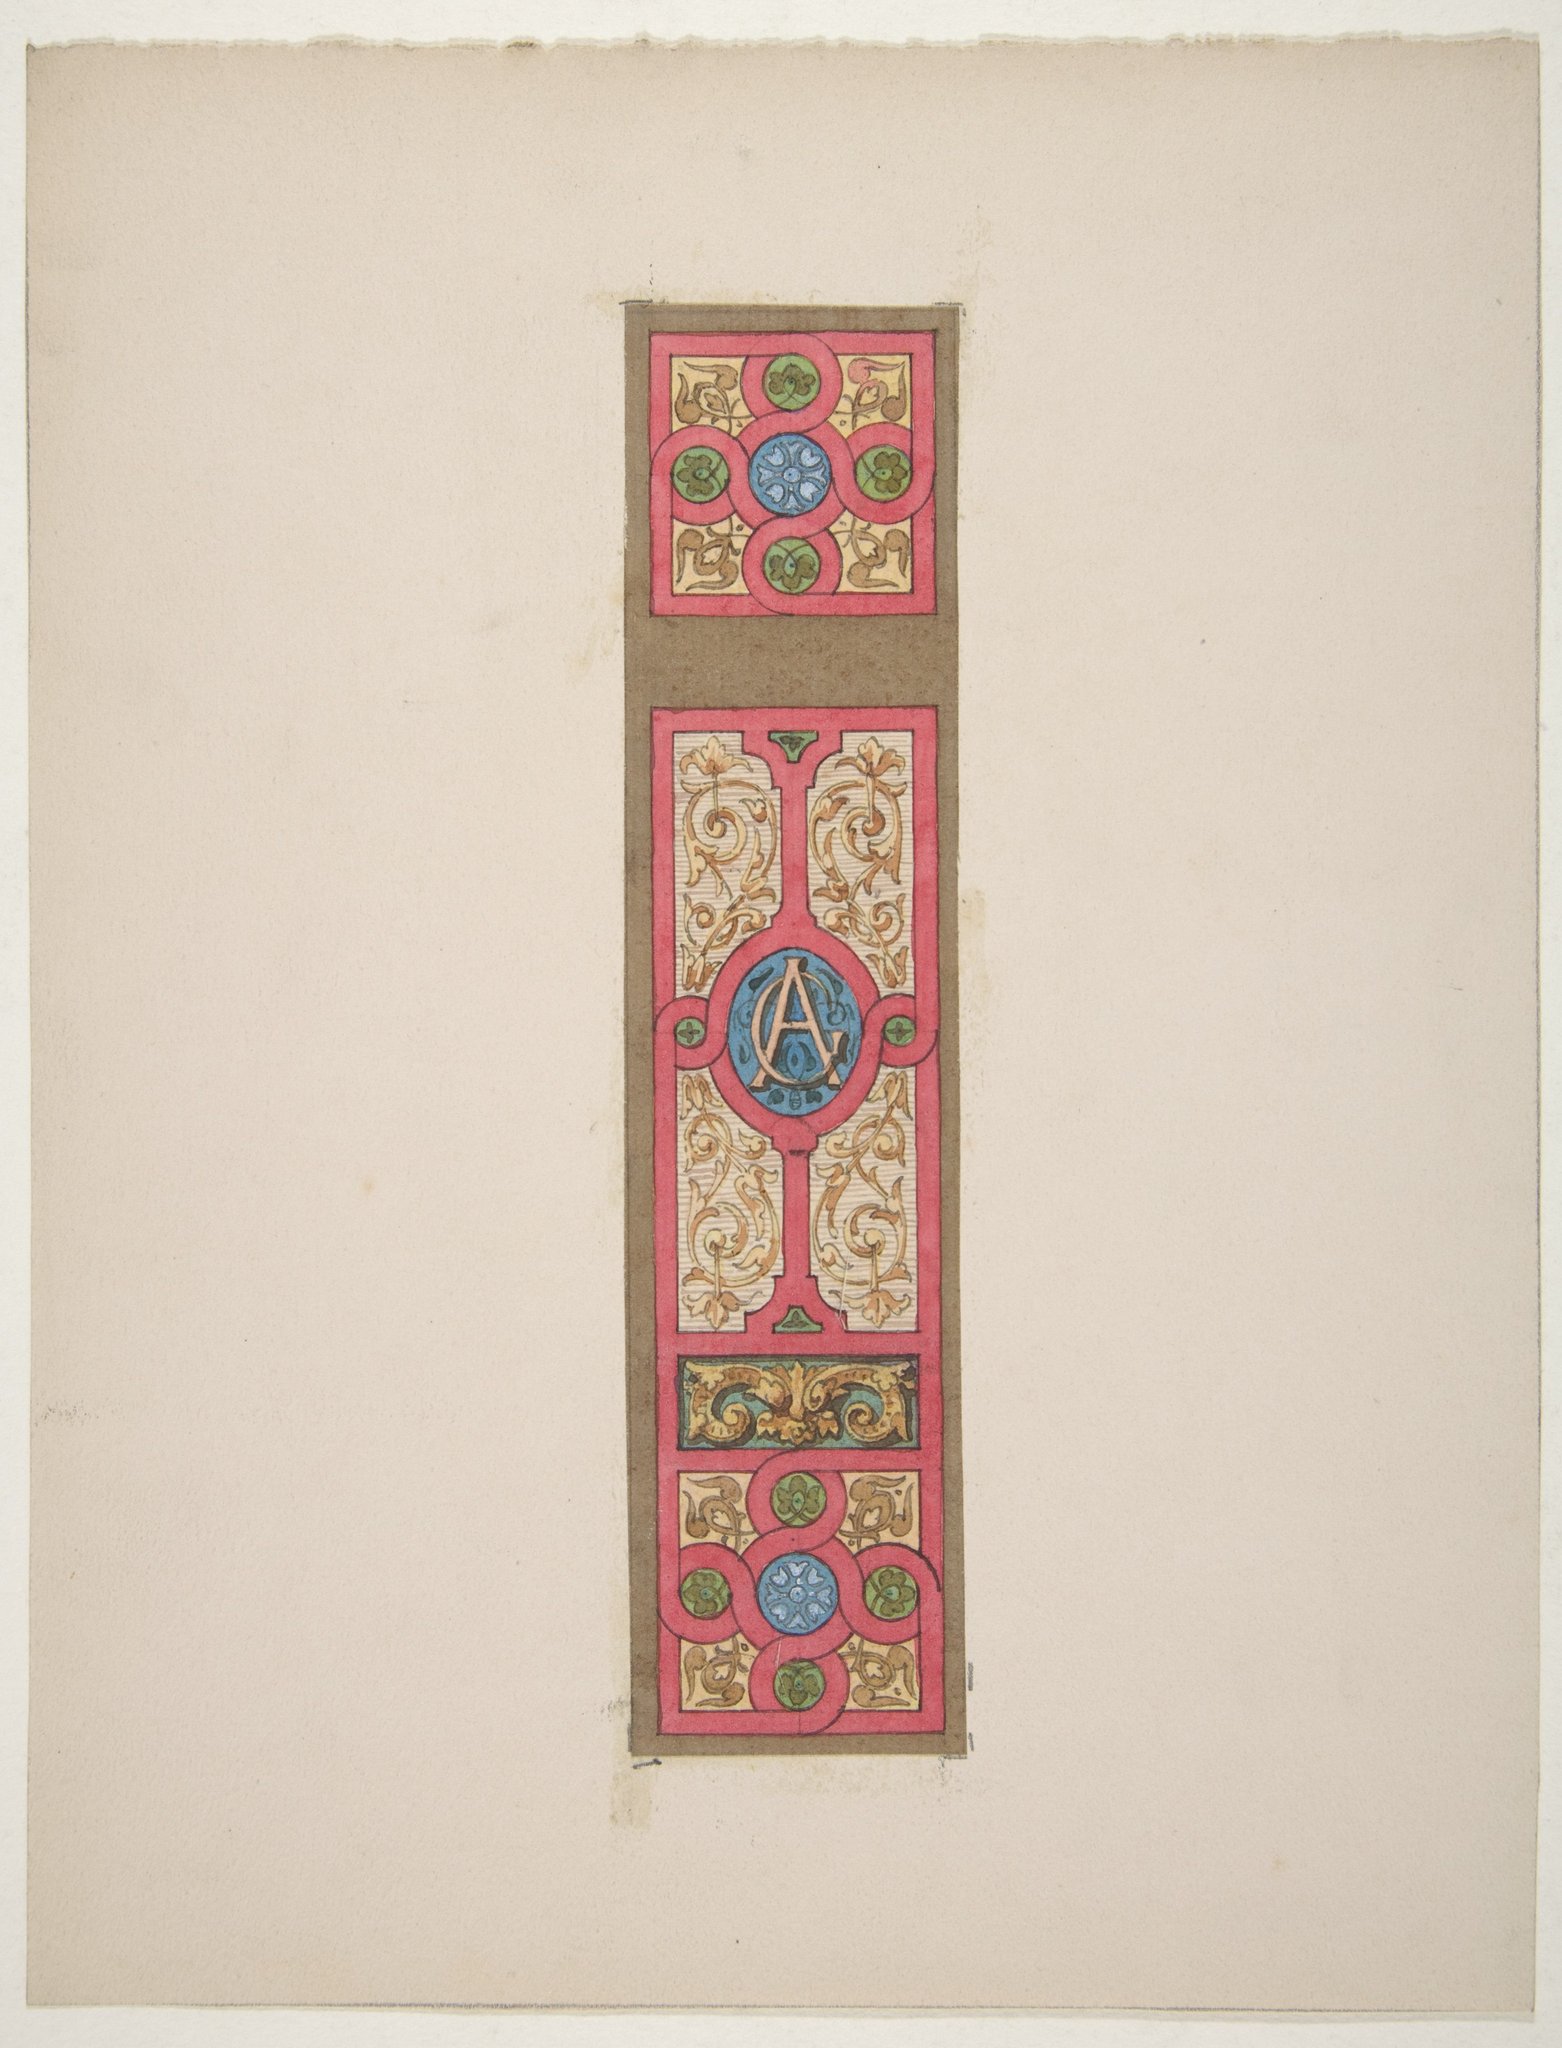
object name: drawing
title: Design for the painted decoration of a wall of ceiling panel monogrammed "CA"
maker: jules-edmond-charles lachaise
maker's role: artist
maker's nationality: french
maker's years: 1897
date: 1851-1900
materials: ink, paper, watercolor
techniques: pen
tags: cartouches,insignia